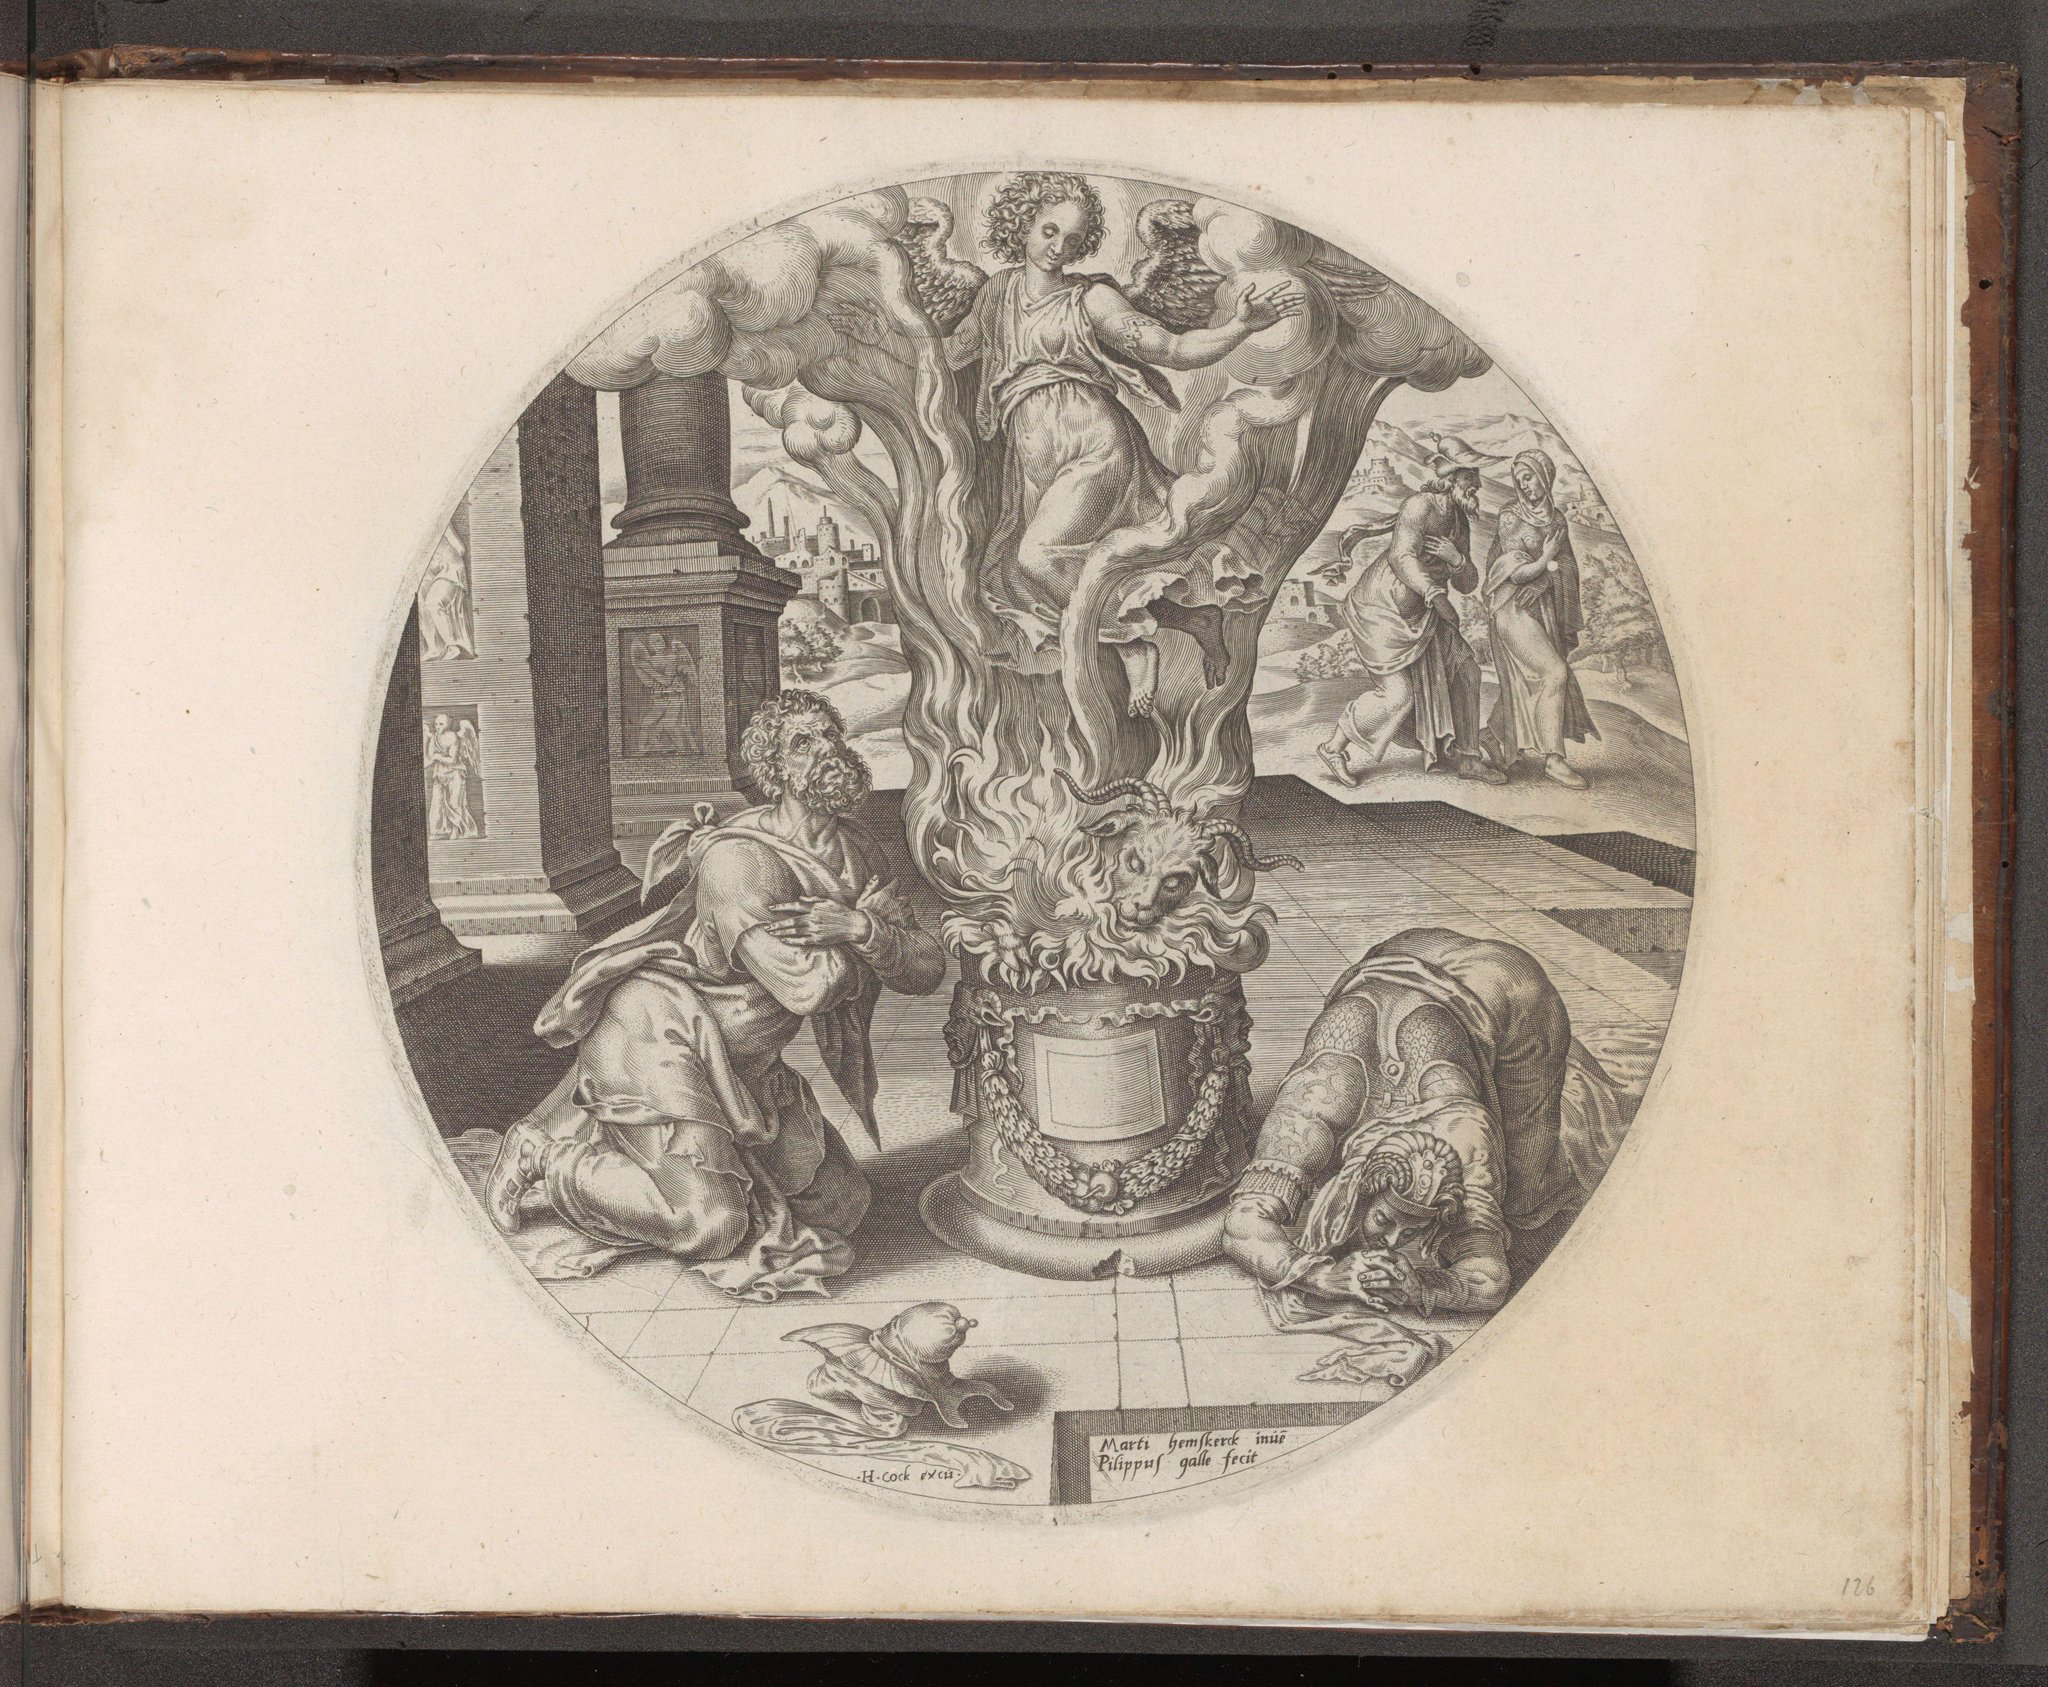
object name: print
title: Offer van Manoach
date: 1558-1562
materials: paper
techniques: engraving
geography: antwerp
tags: manoah's sacrifice; the angel ascends in the flames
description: Manoach en zijn vrouw werpen zich neer bij het altaar, waar Manoach een geit offerde. De aartsengel Gabriël, die Manoach en zijn vrouw de geboorte van een zoon aankondigde, vaart in de vlammen van het offer ten hemel. Prent maakt deel uit van een album.